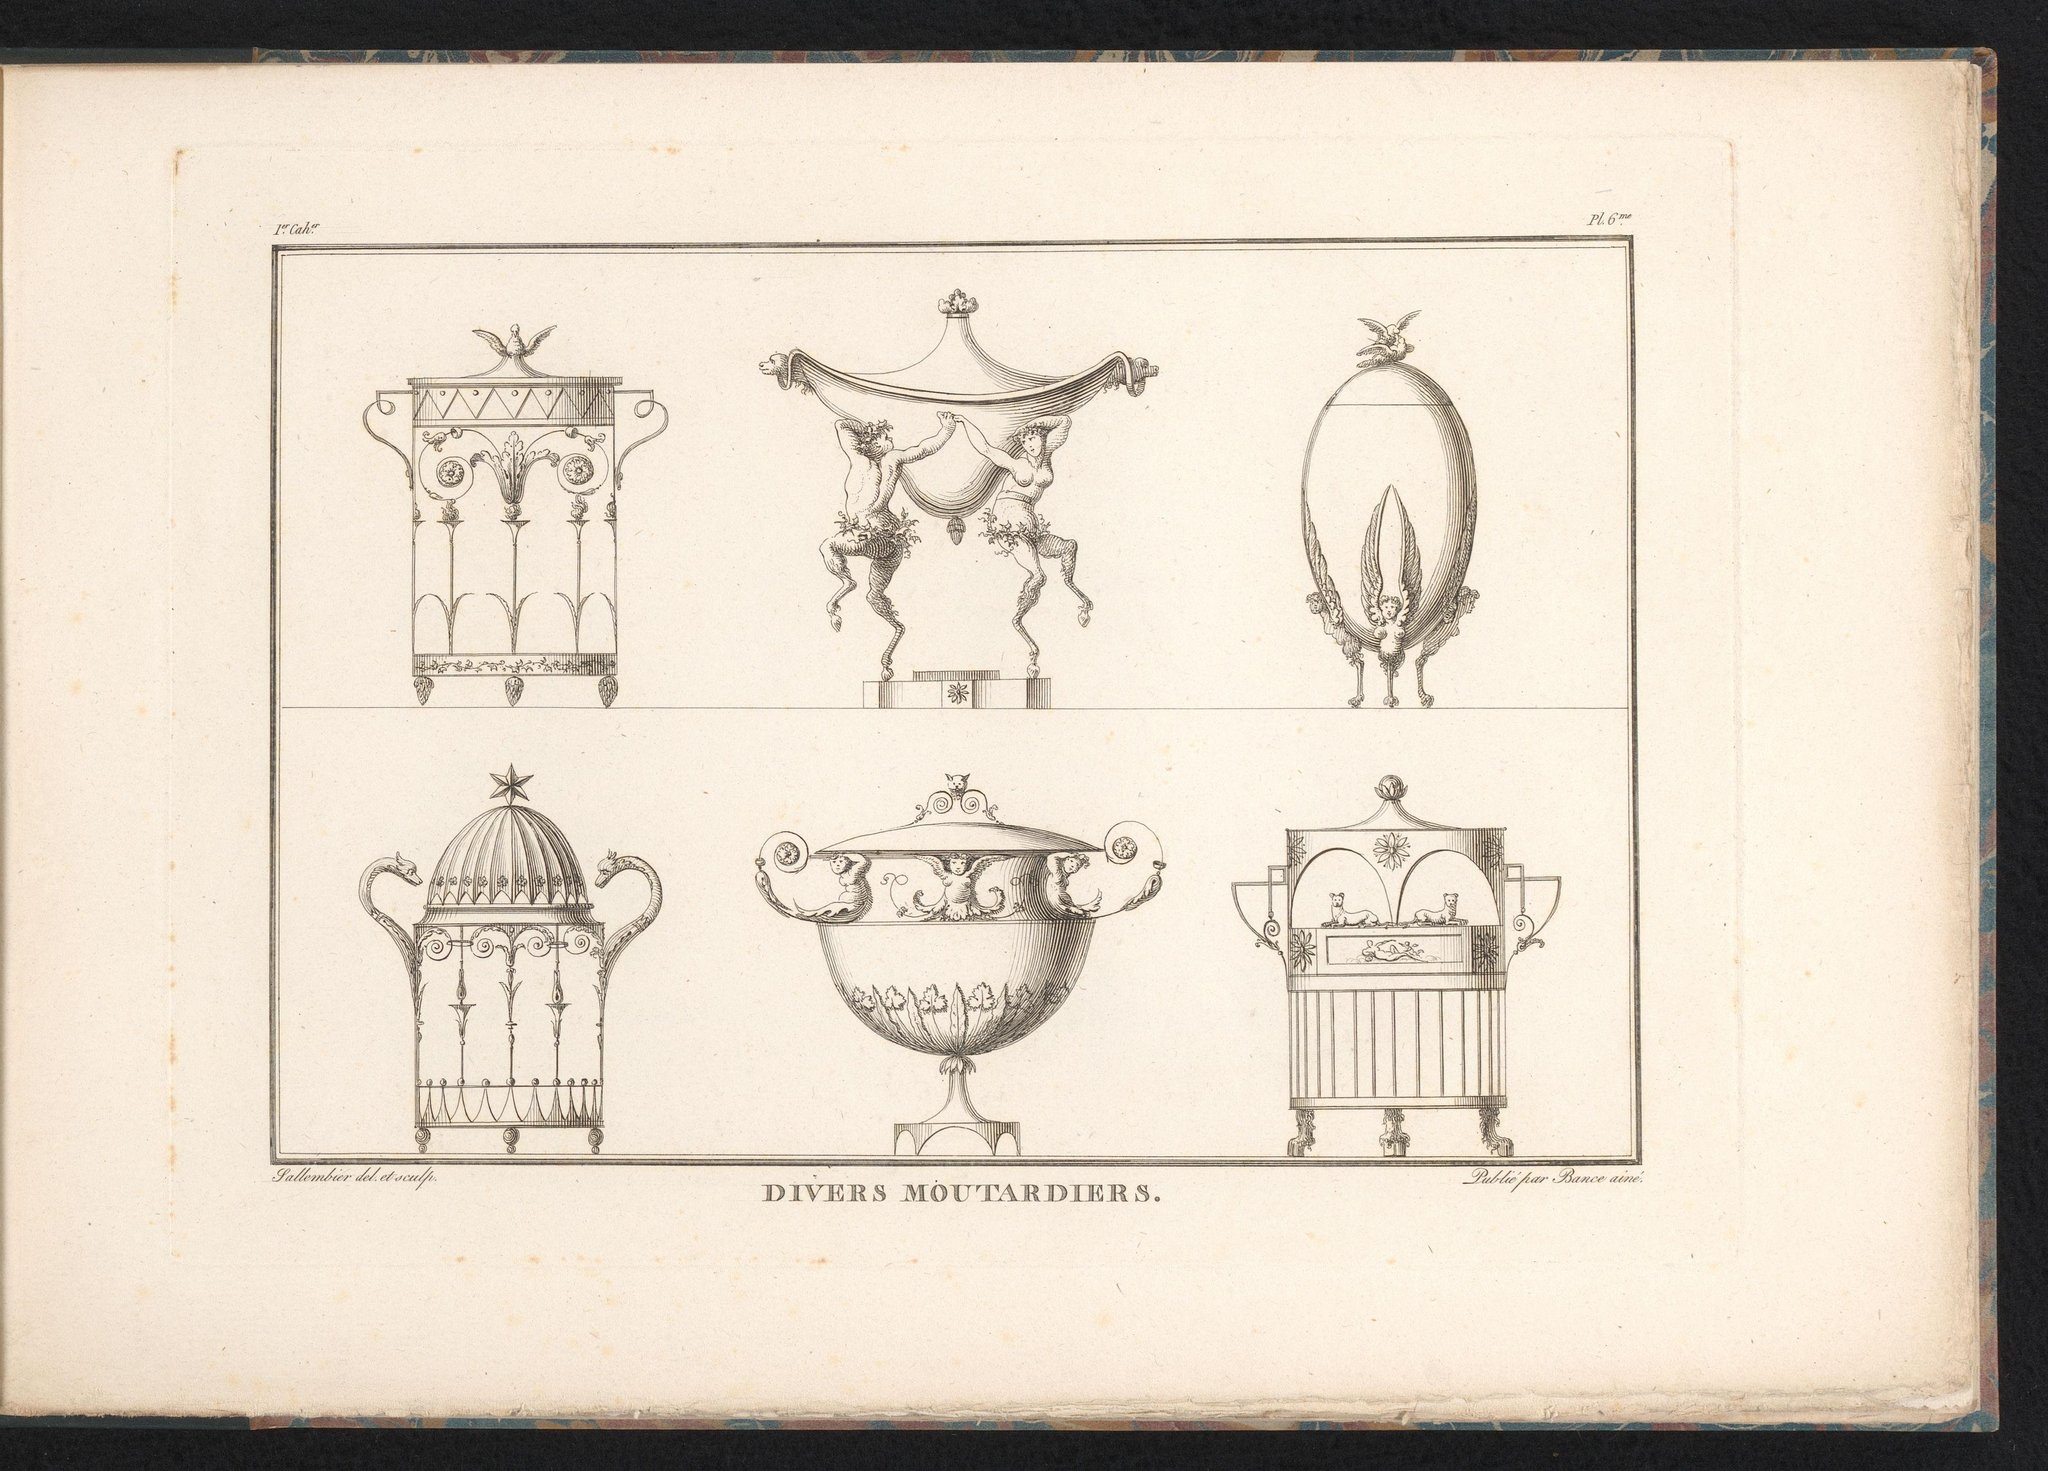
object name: album leaf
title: Ontwerpen voor edelsmeedkunst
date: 1805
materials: paper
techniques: etching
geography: paris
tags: mustard, sphinx (lion/woman); 'sfinge' (ripa), foliage ~ ornament, dinner-service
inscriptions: number: ‘1.er Cah.er’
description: Ontwerpen voor mosterdpotten met saters, Griekse sfinxen en bladmotieven. Prent maakt deel uit van een album.